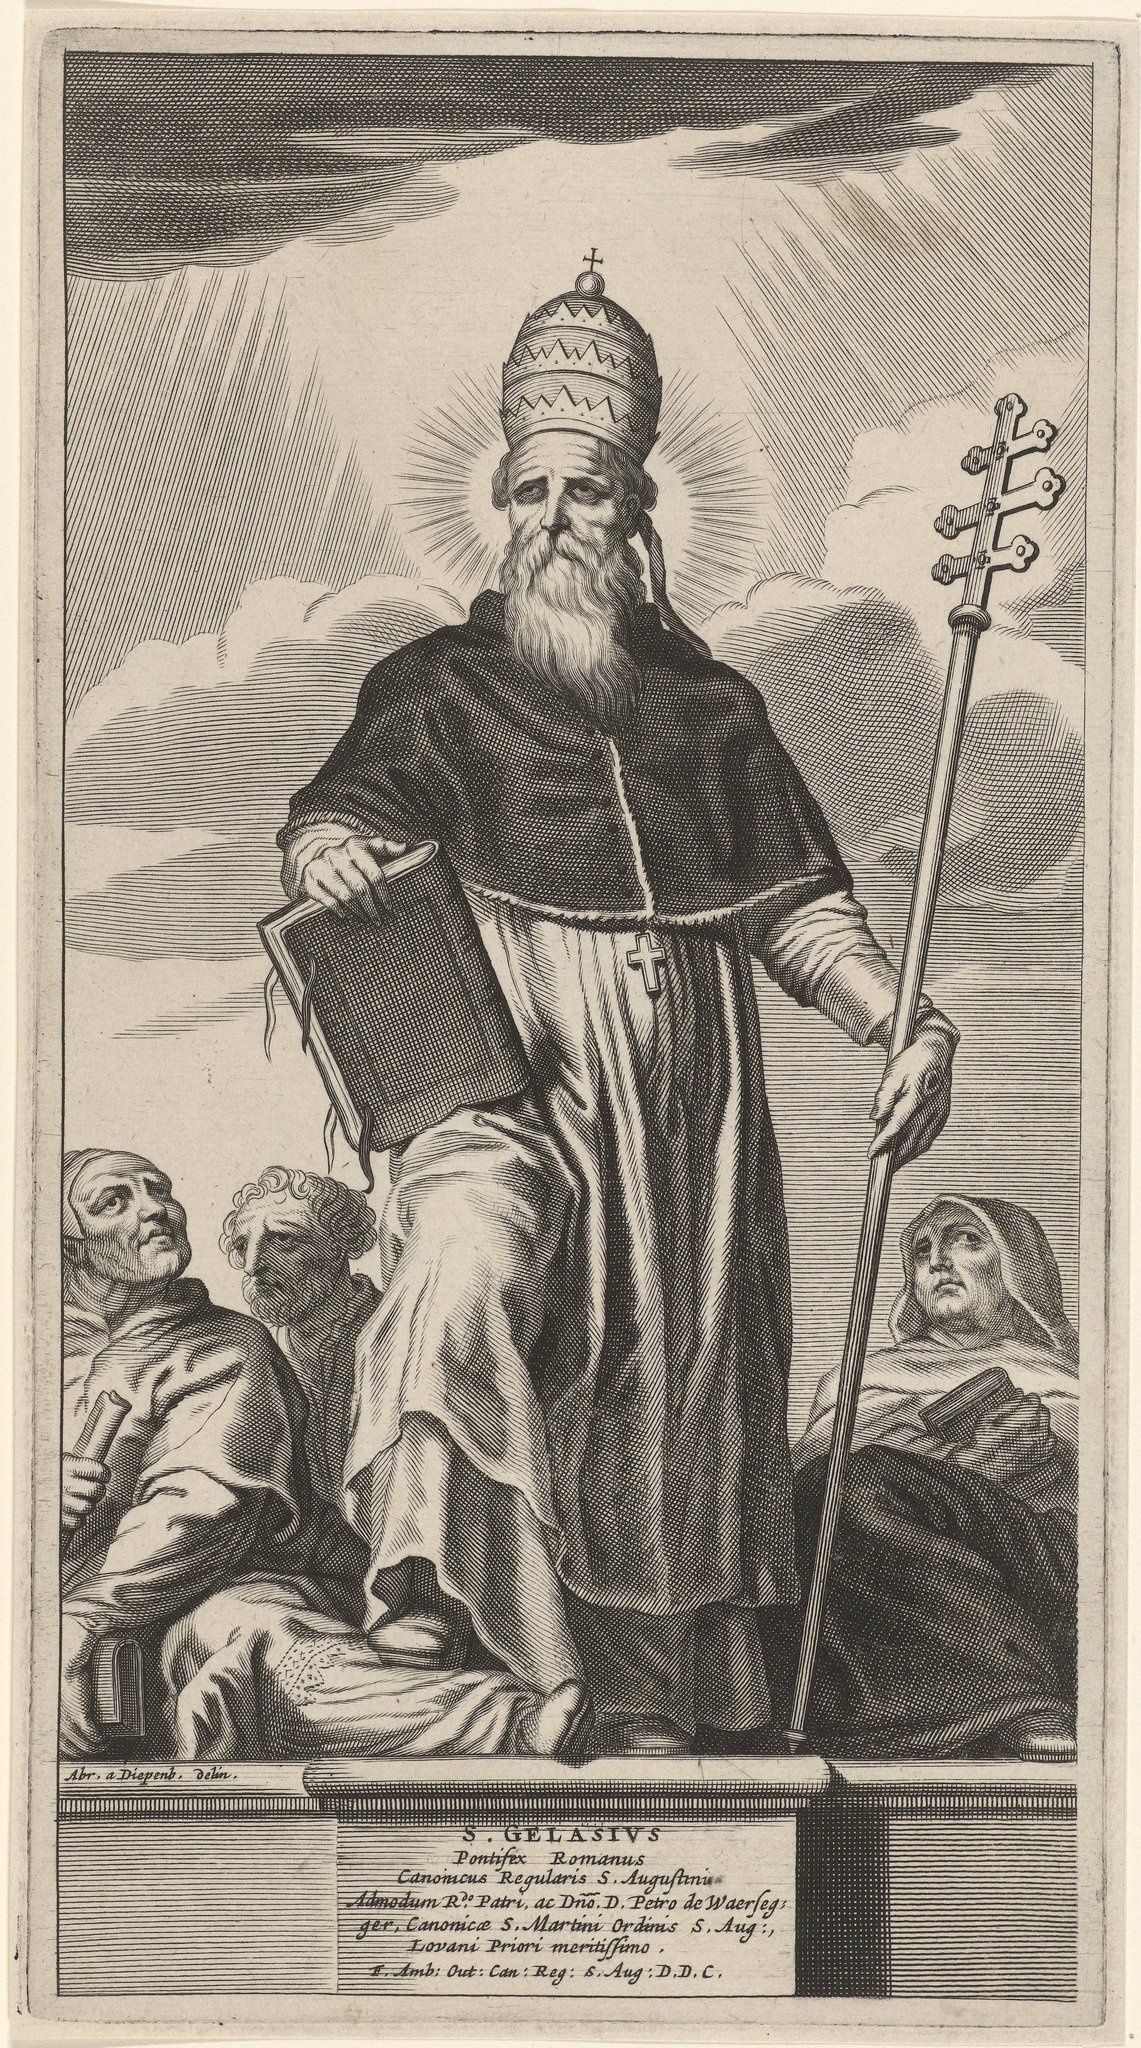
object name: print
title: H. Gelasius II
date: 1615-1676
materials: paper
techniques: engraving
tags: gaeta, gelasius ii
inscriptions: collector's mark: Lugt 240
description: De heilige Gelasius II, met pauselijke tiara. Prent uit een serie van acht prenten met heiligen.